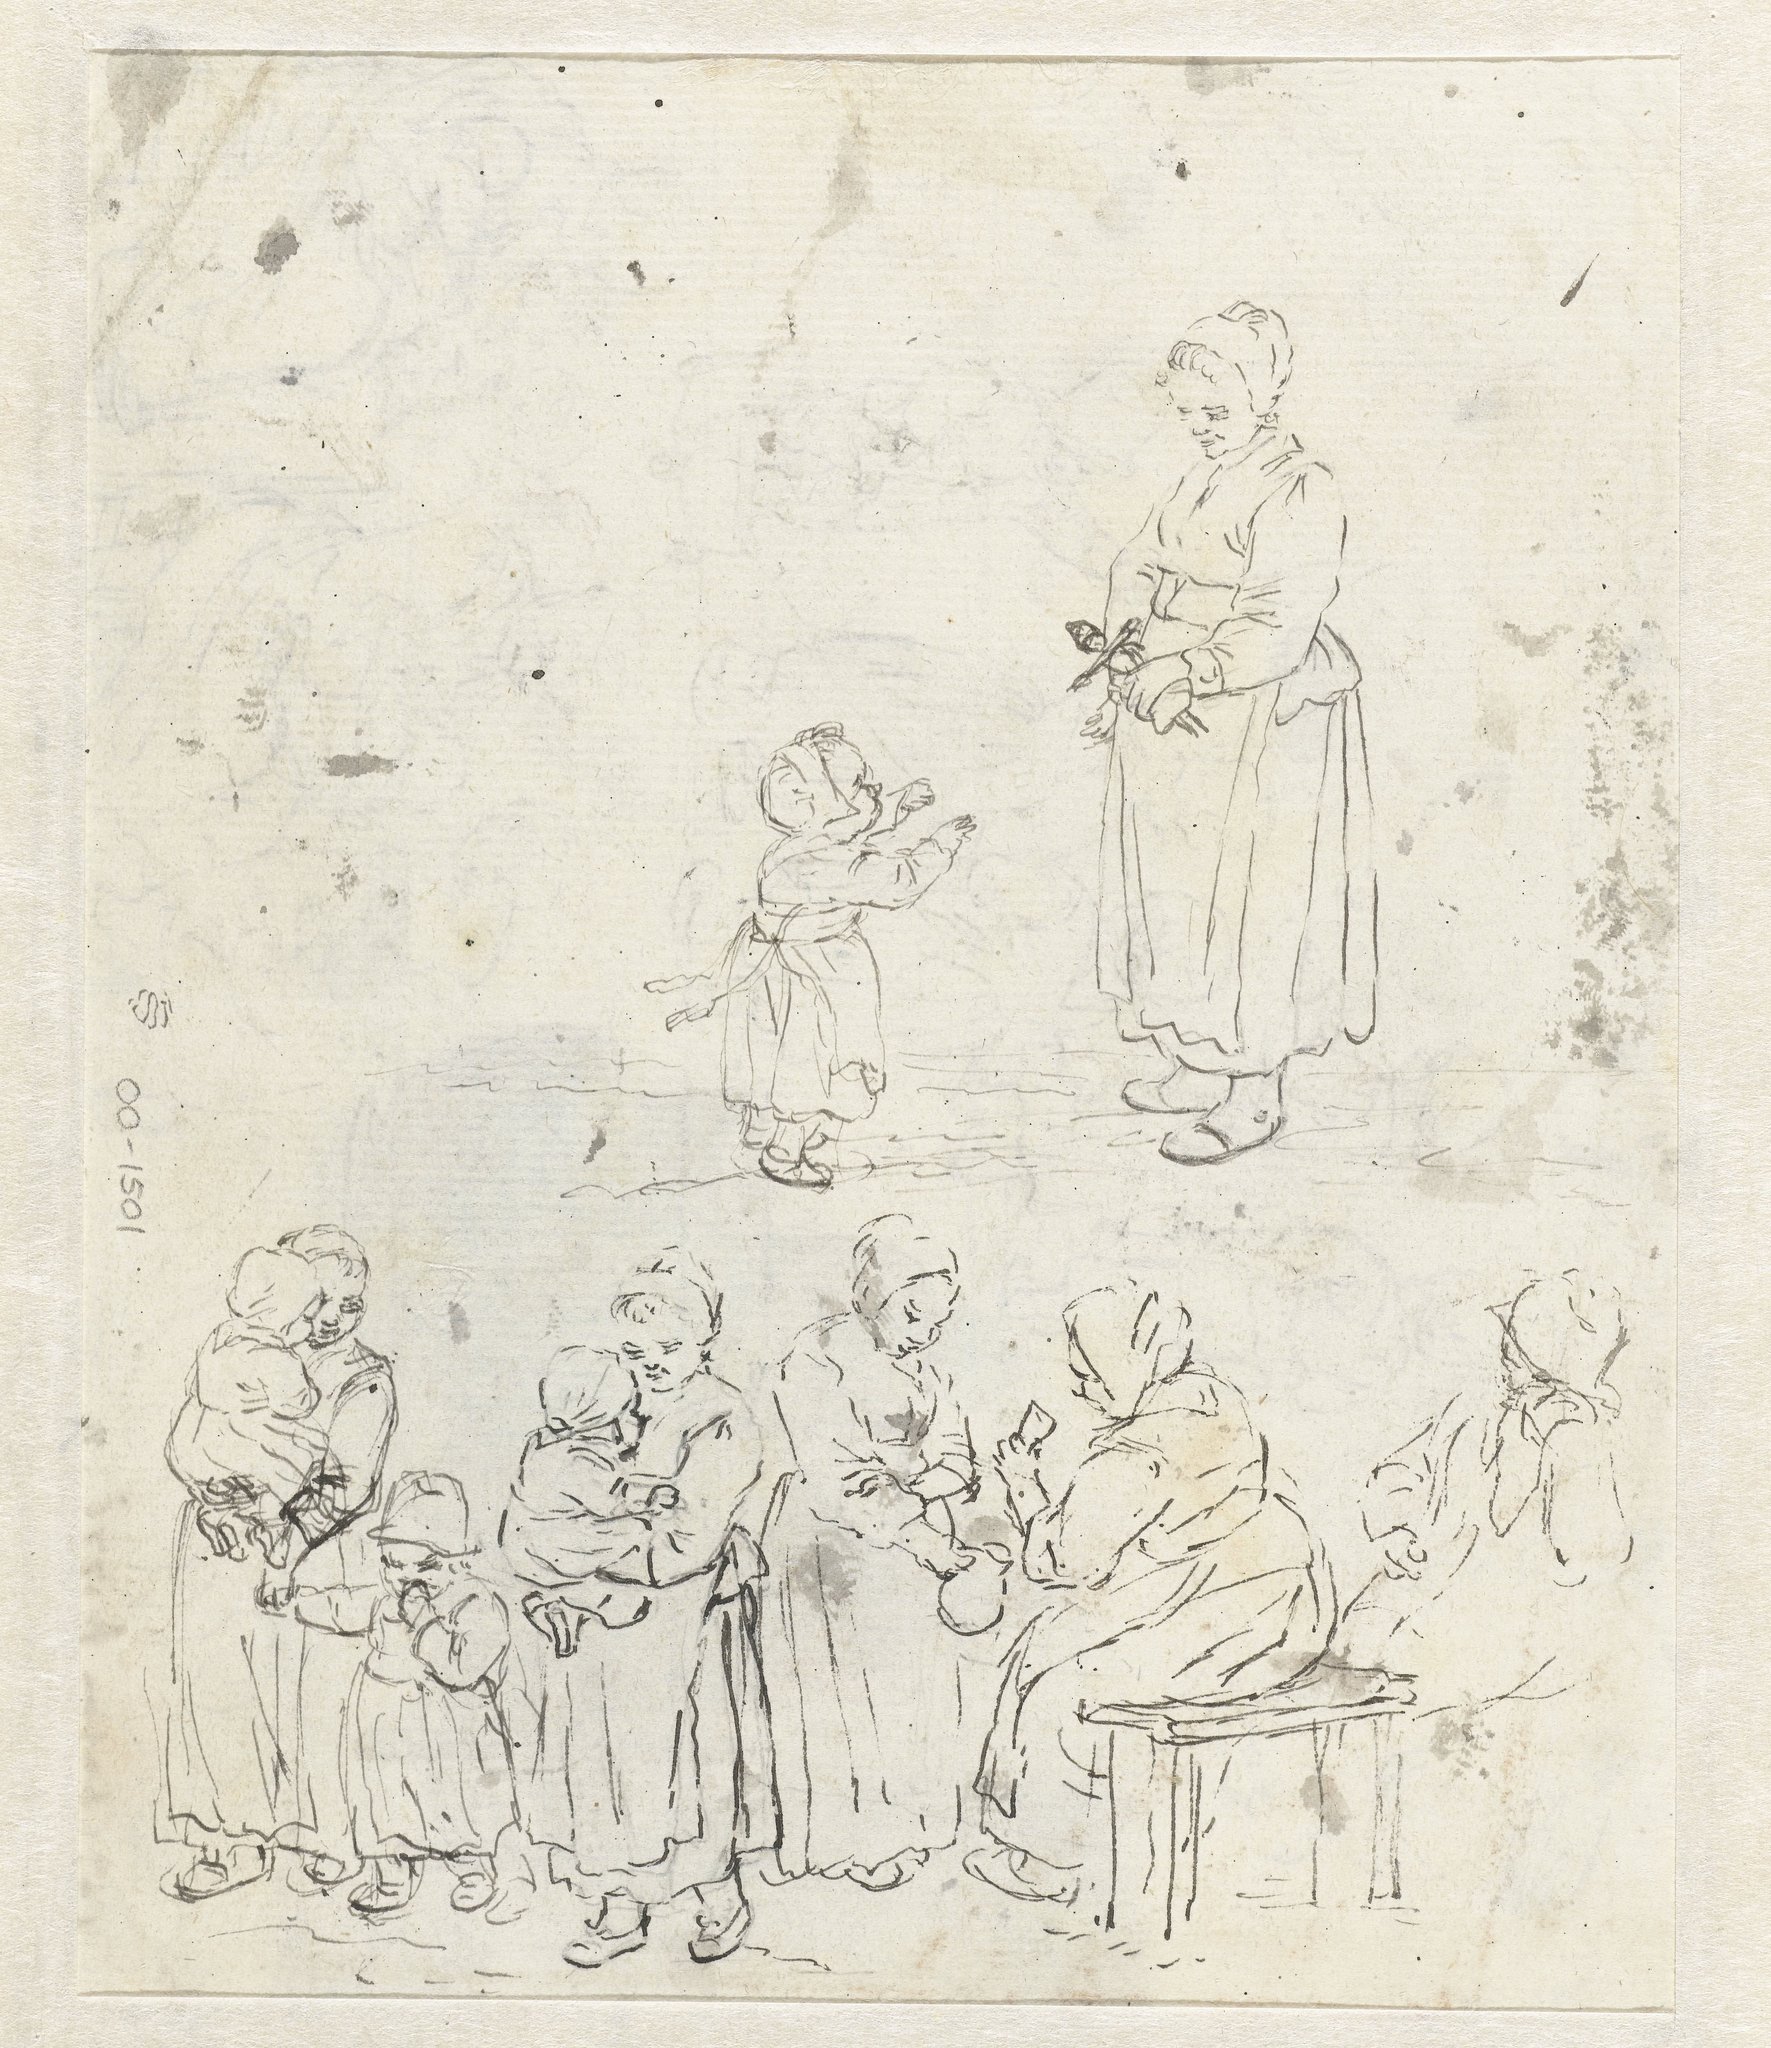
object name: drawing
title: Studies van moeders en kinderen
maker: christina chalon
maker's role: draughtsman, print maker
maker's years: 1748-1808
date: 1771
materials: ink, paper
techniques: pen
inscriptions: date